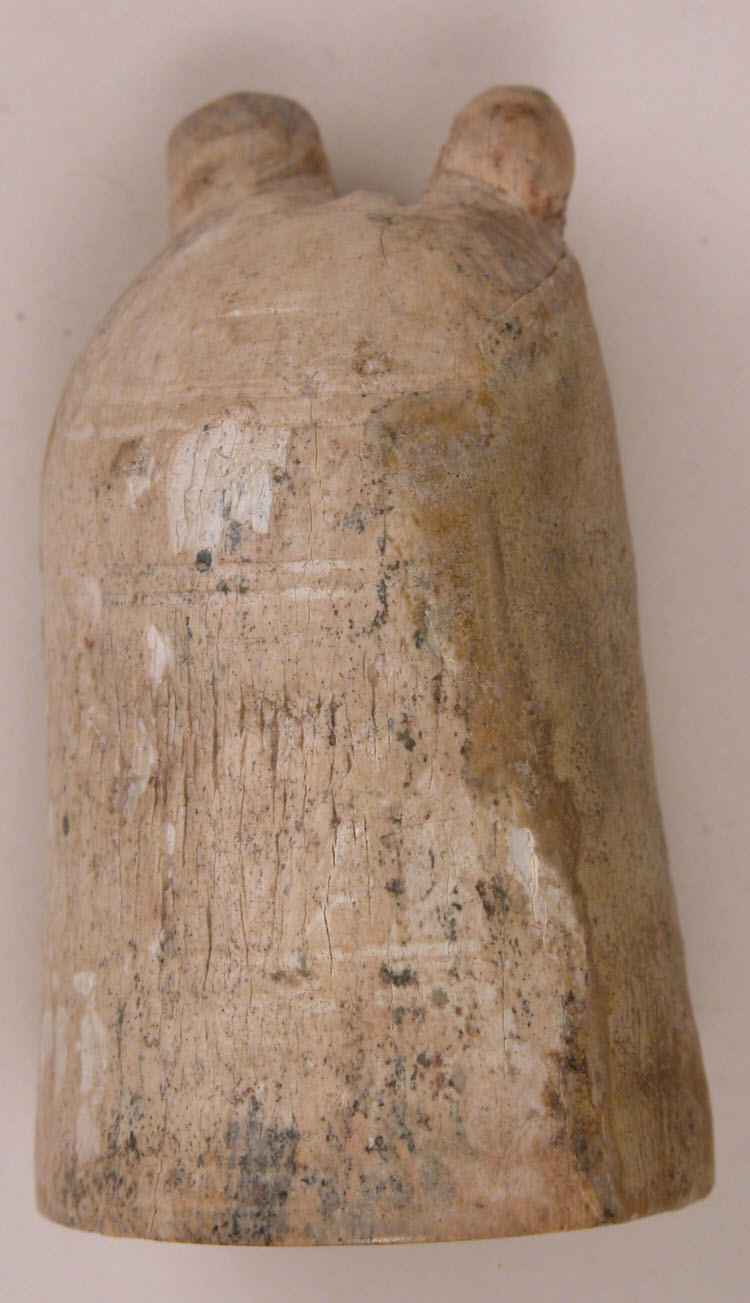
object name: chess piece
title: Chess Piece, Bishop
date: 701-1000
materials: ivory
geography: western islamic lands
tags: chess